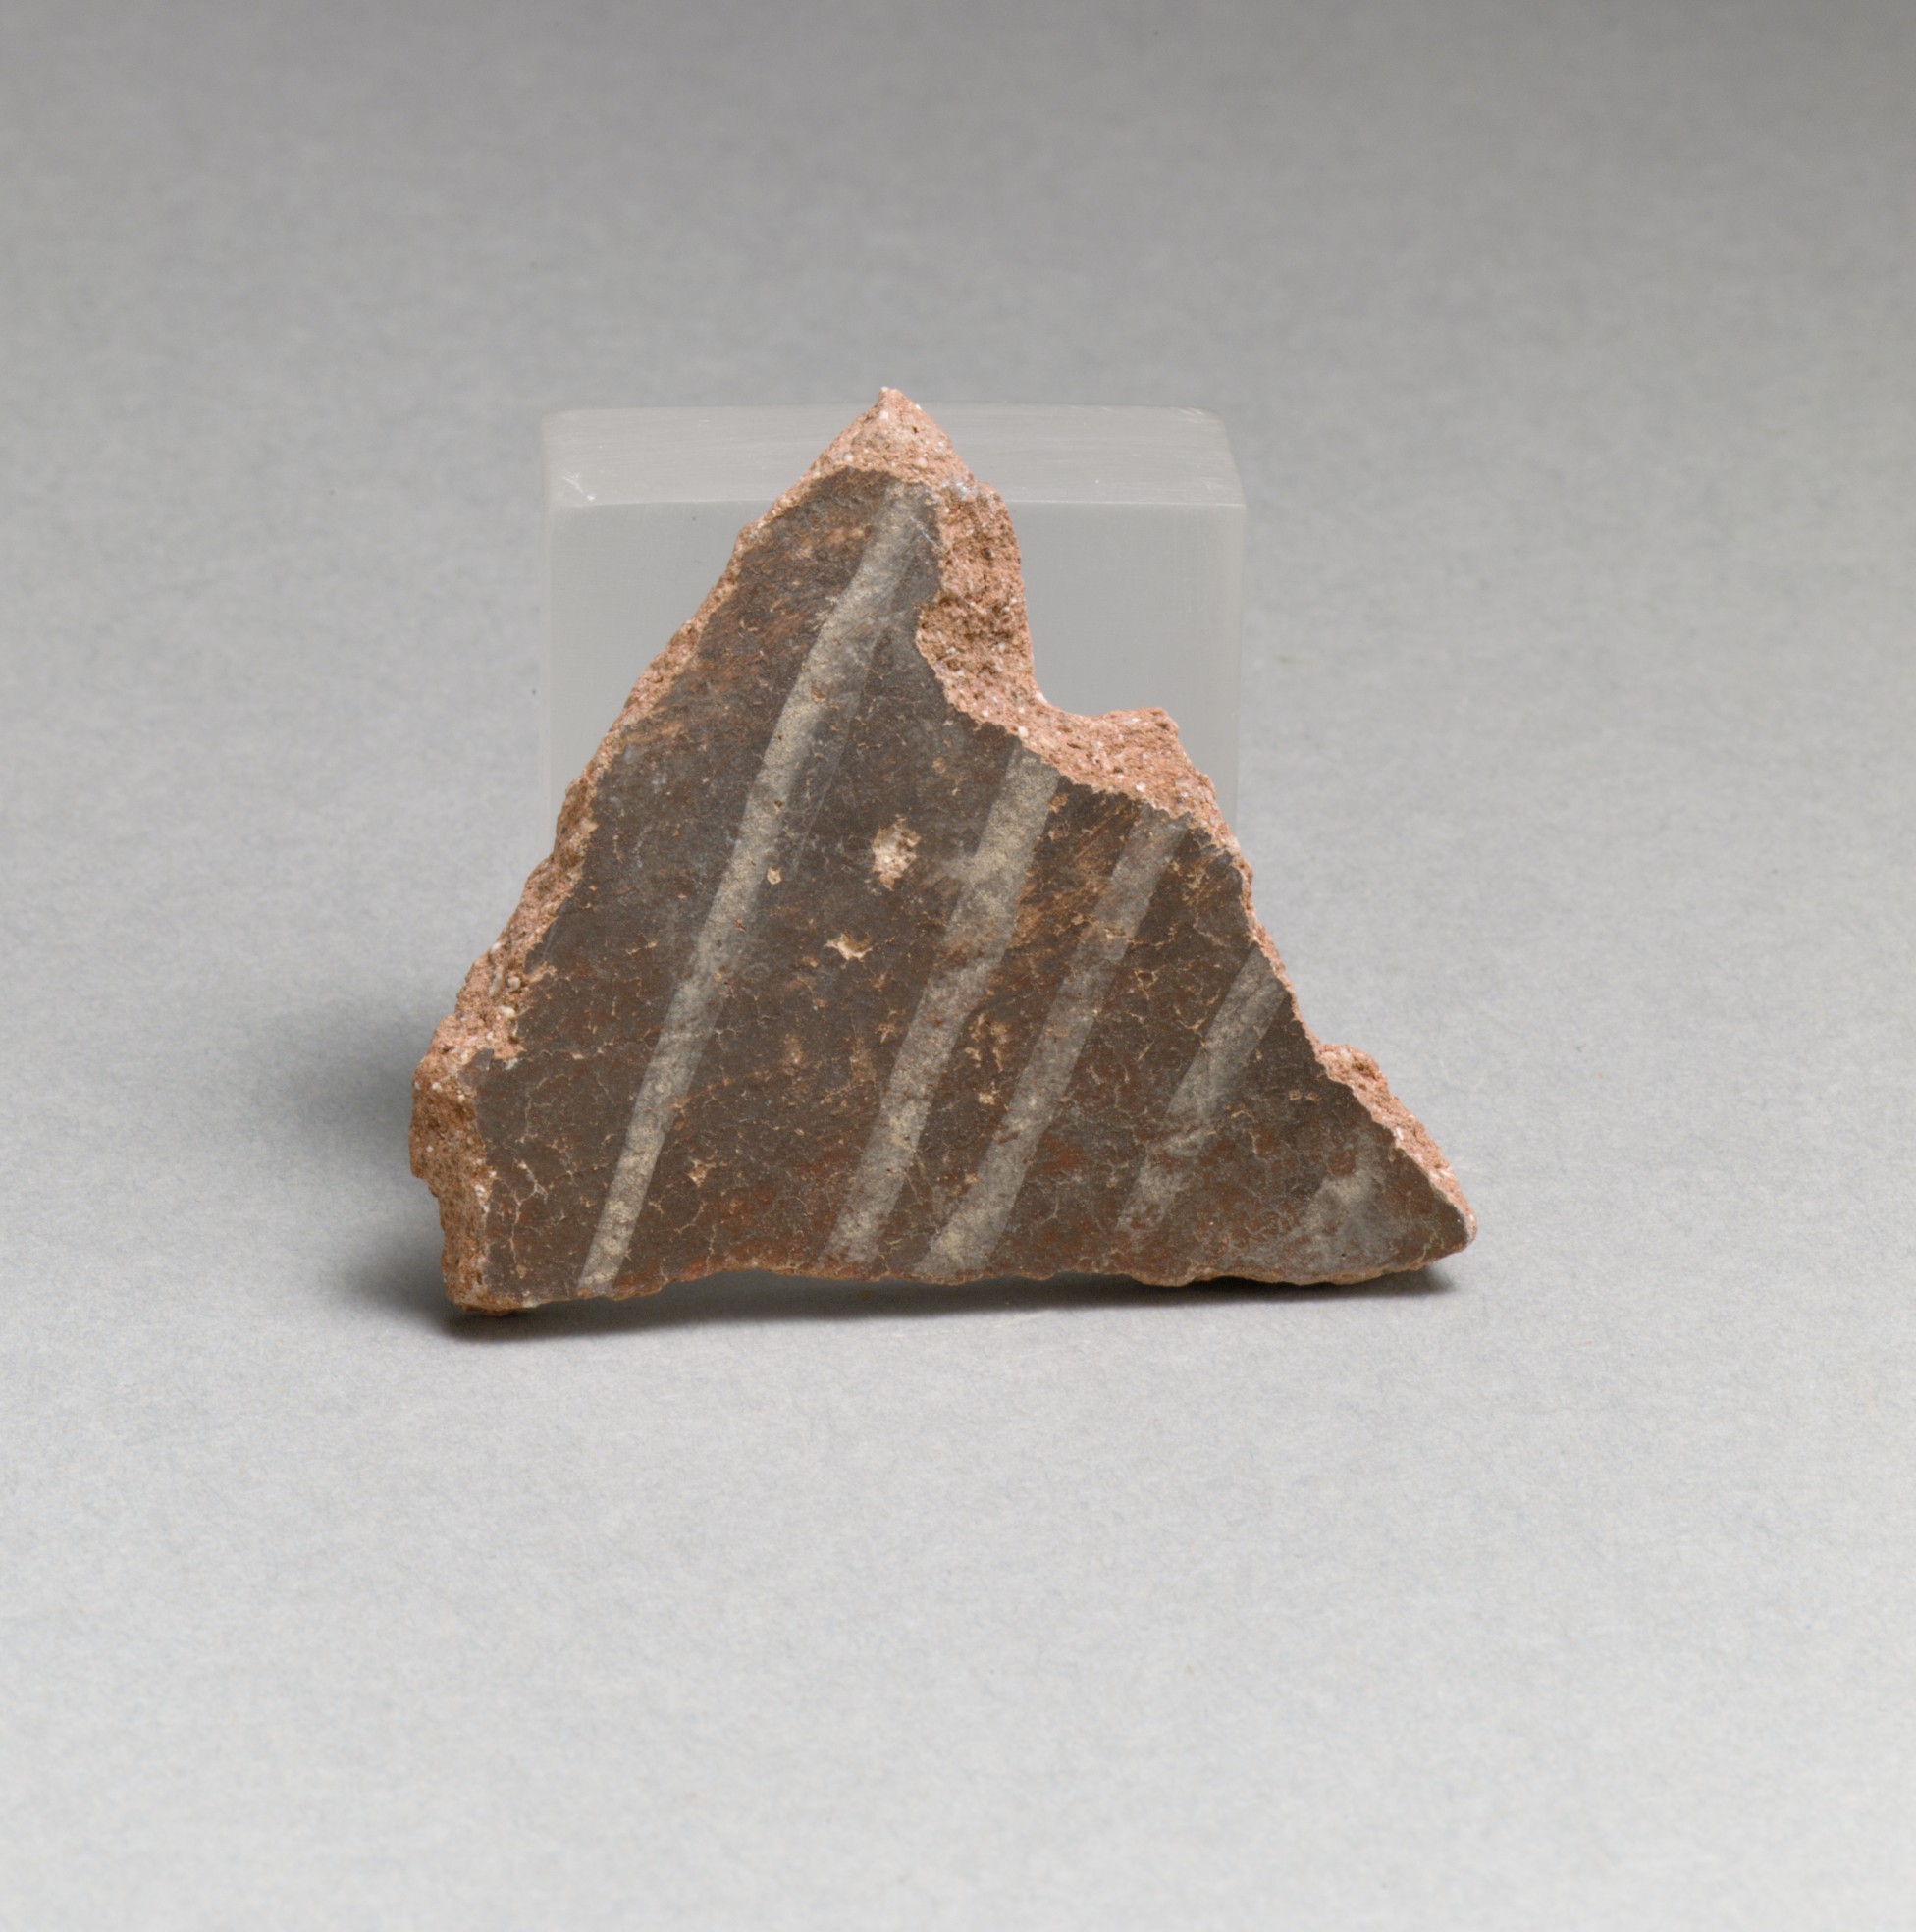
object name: vase fragment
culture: minoan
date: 2600-2000 BCE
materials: terracotta